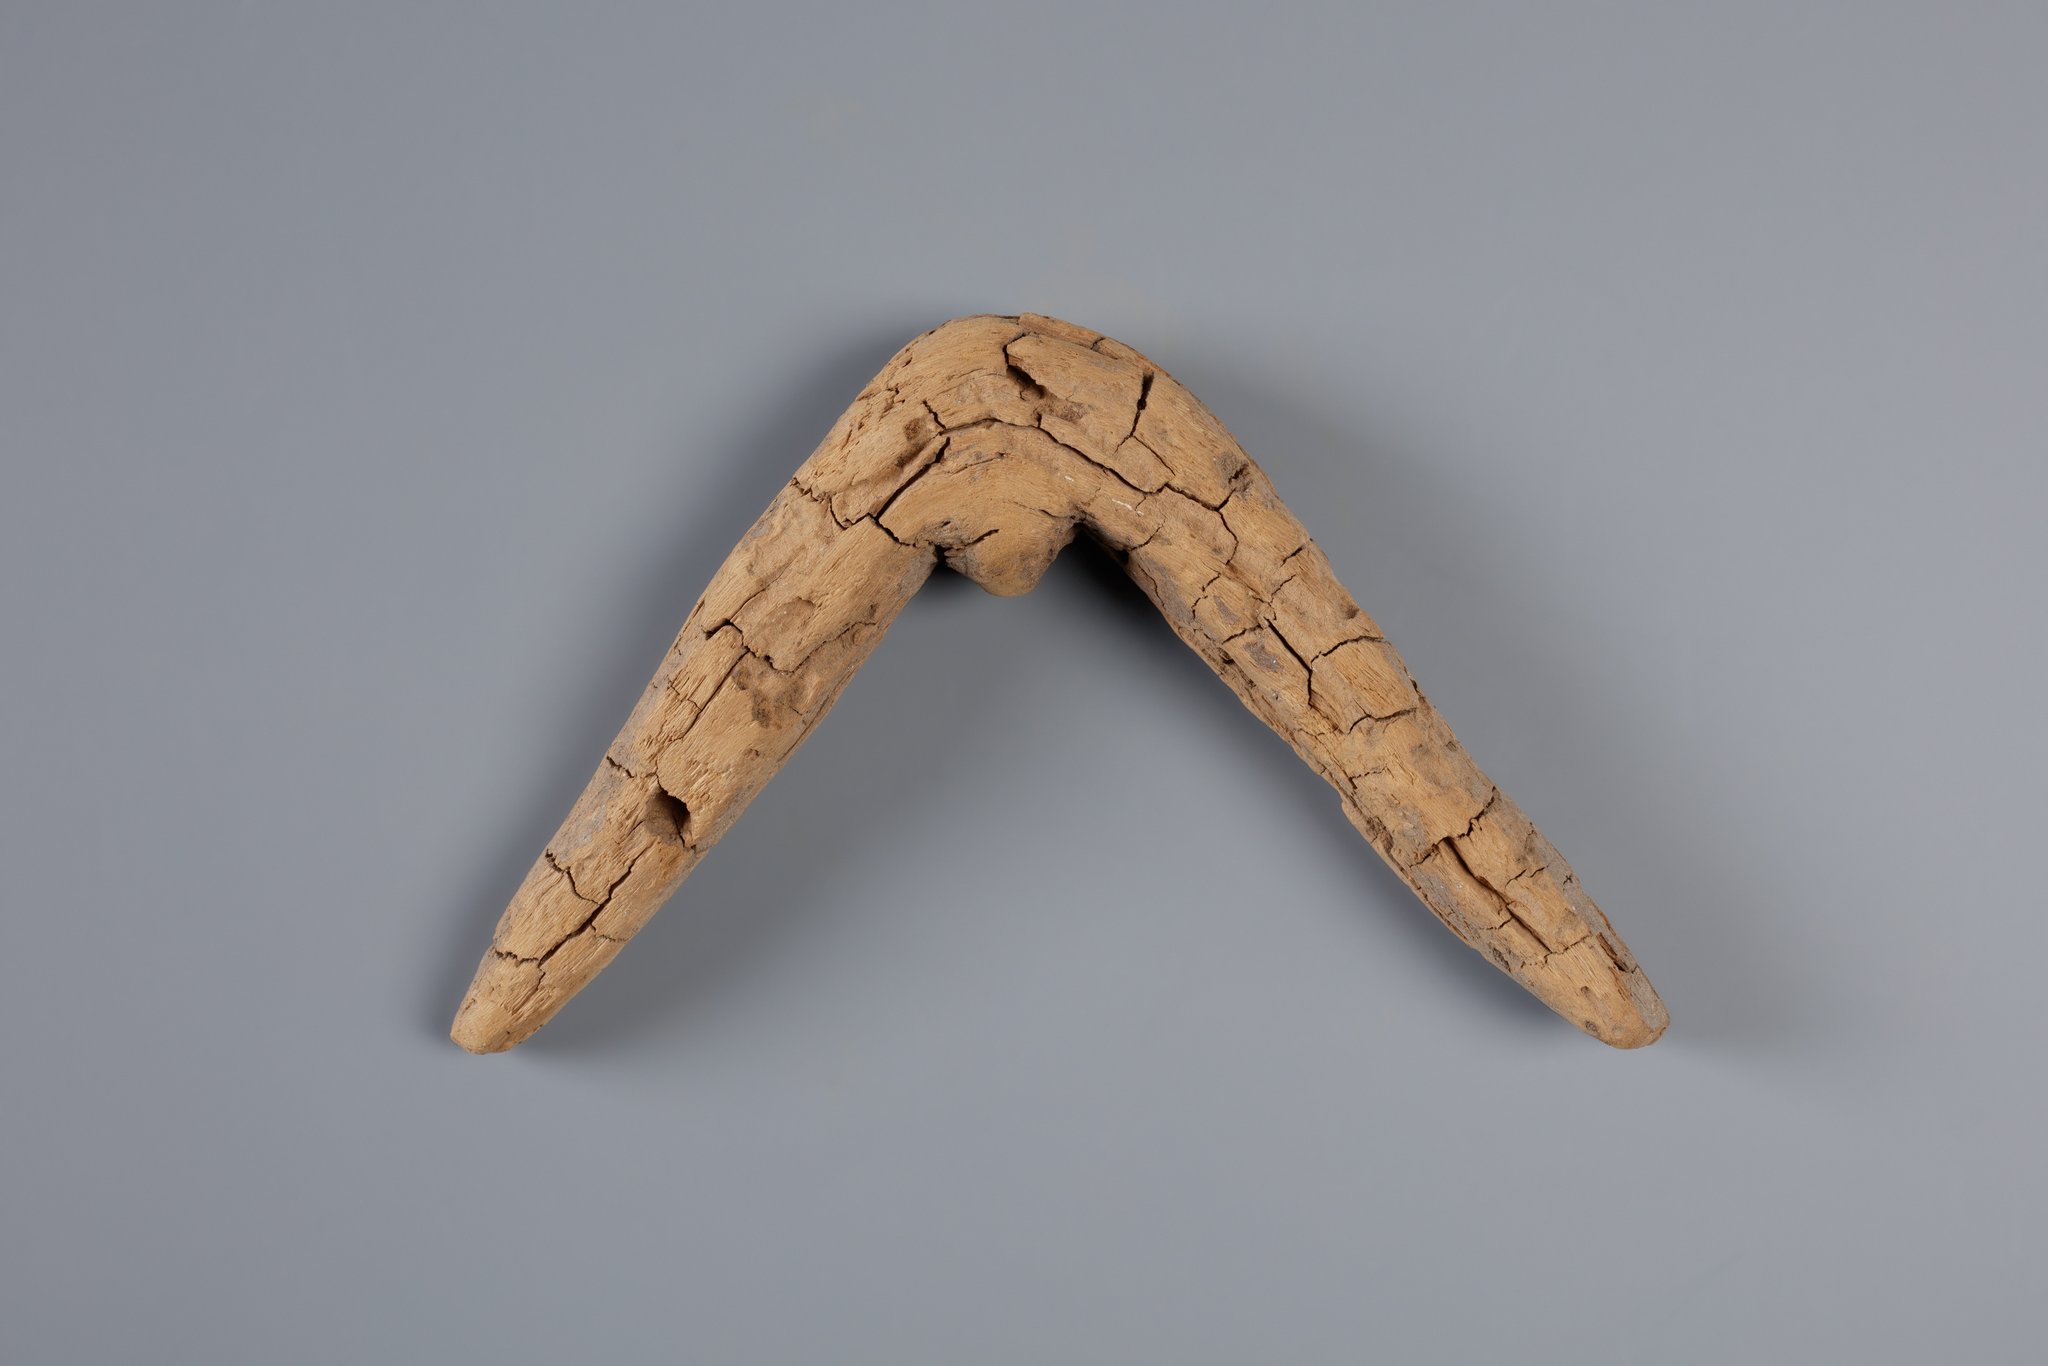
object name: donkey rig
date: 1295-1070 BCE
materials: wood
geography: egypt